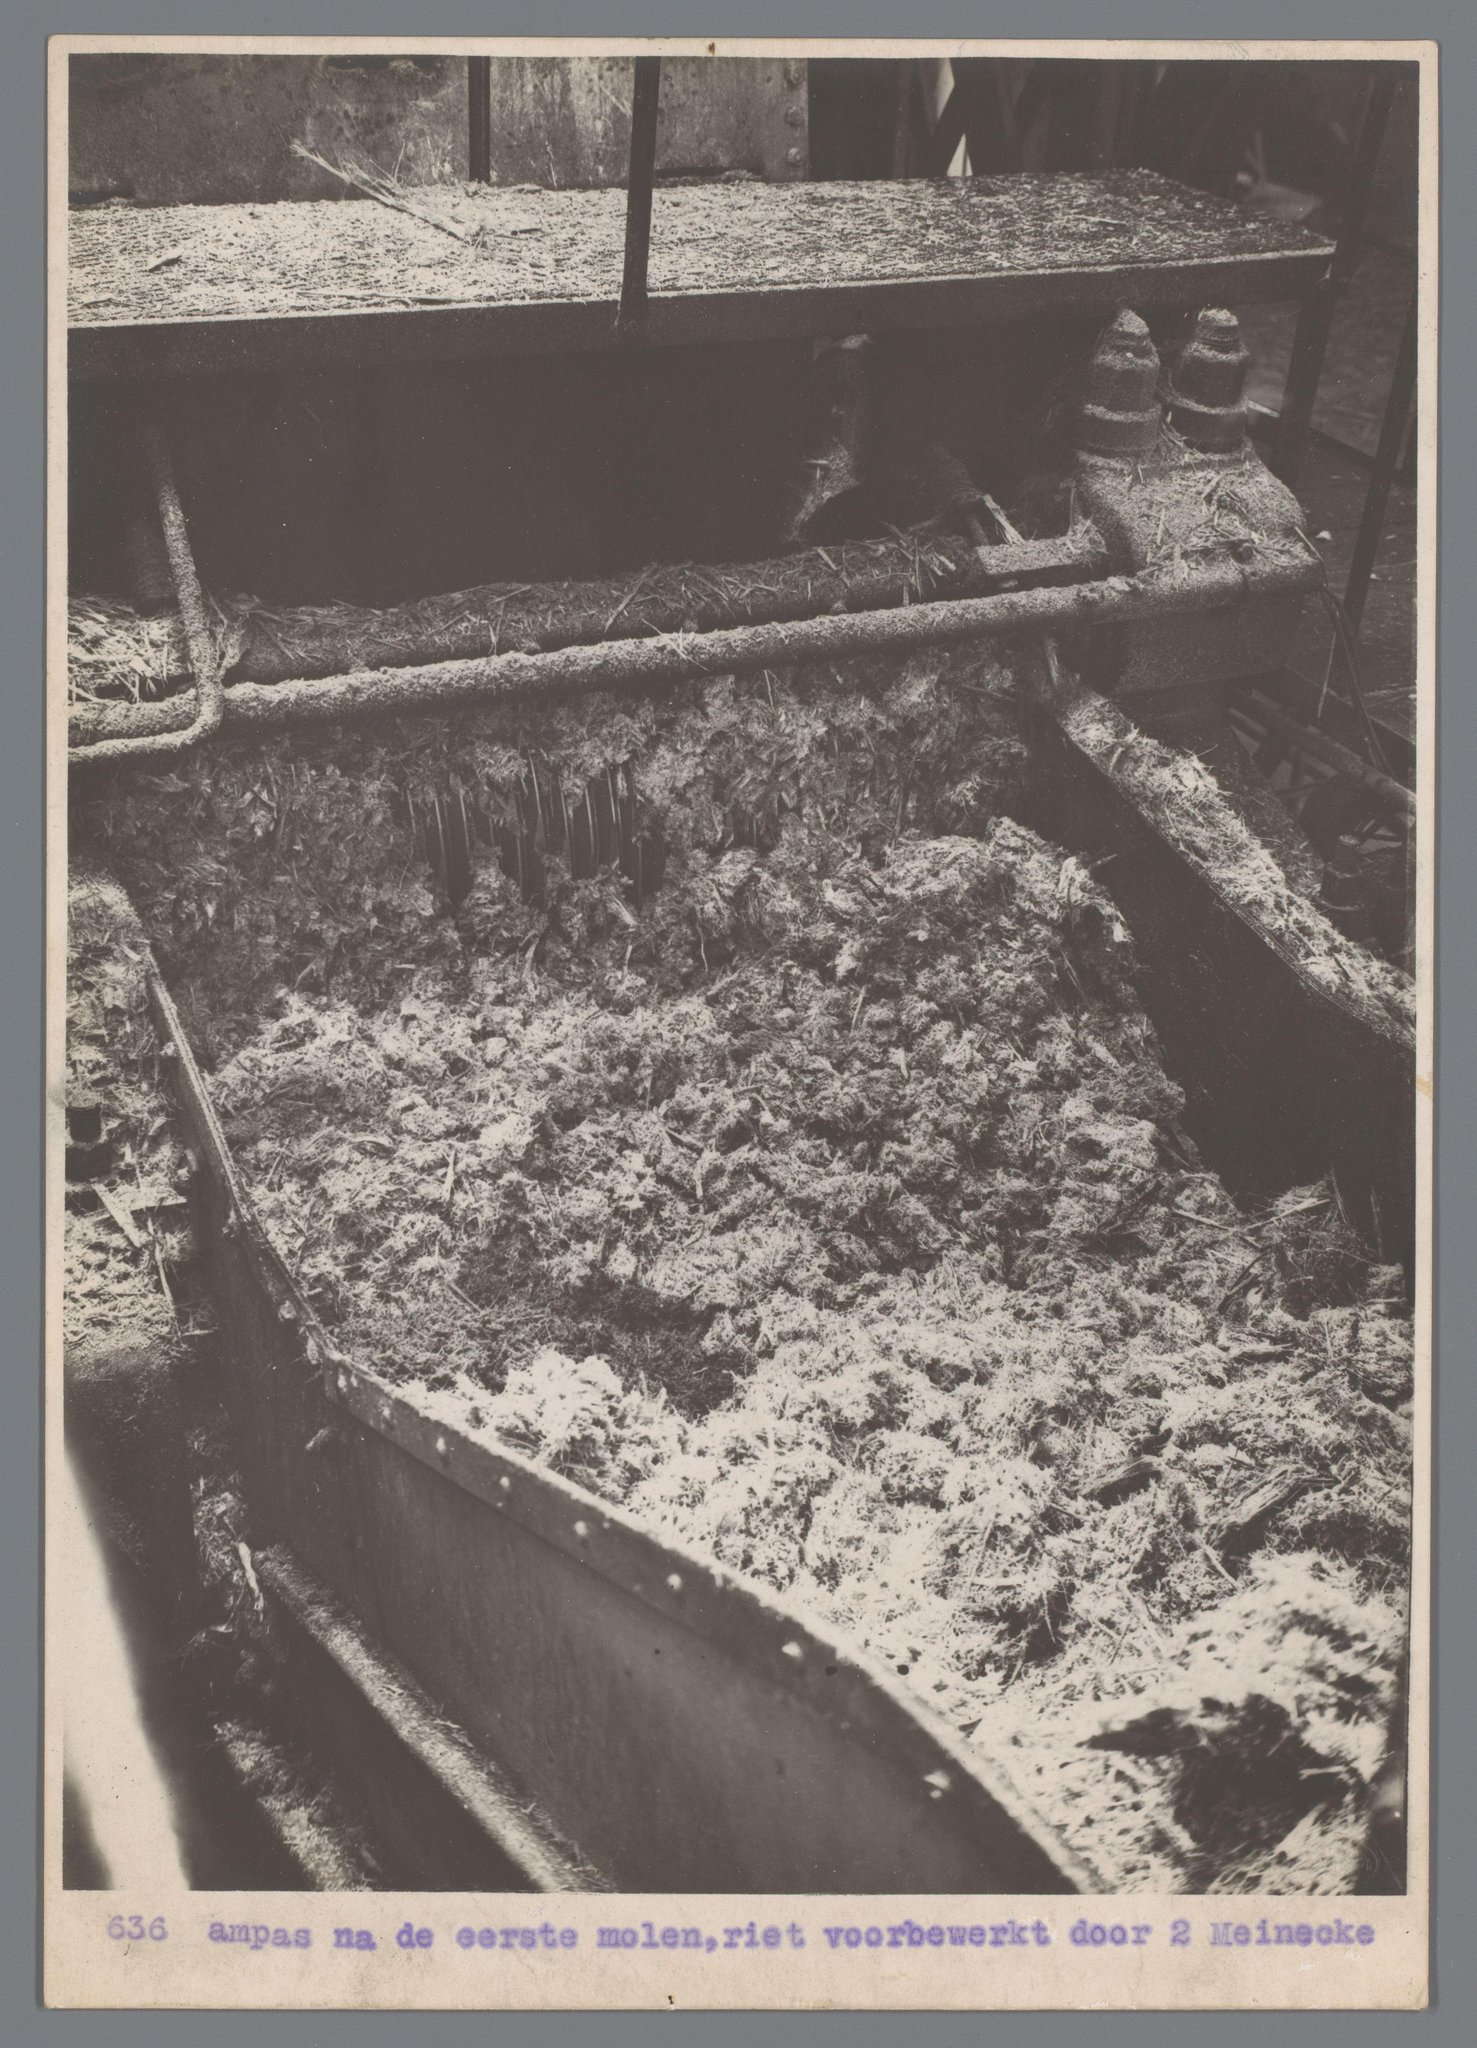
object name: photograph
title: Ampas na de eerste molen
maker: otto hisgen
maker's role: fotograaf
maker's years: 1874-1944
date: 1906-1937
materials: photographic support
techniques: gelatin silver print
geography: semarang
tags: colonial system, machines; parts of machines; tools and appliances, (non-fruit) products of plants or trees: sugarcane, interior of industrial structures (regardless of the materials processed or the products made, java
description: Ampas na eerste maling door de canecutter, in een onbekende suikerfabriek in 1937. Onderdeel van de multomap met foto's van machines van de N.V. Machinefabriek Braat te Soerabaja bestemd voor de Nederlandse suikerindustrie op Java, uit de periode 1917-1938.